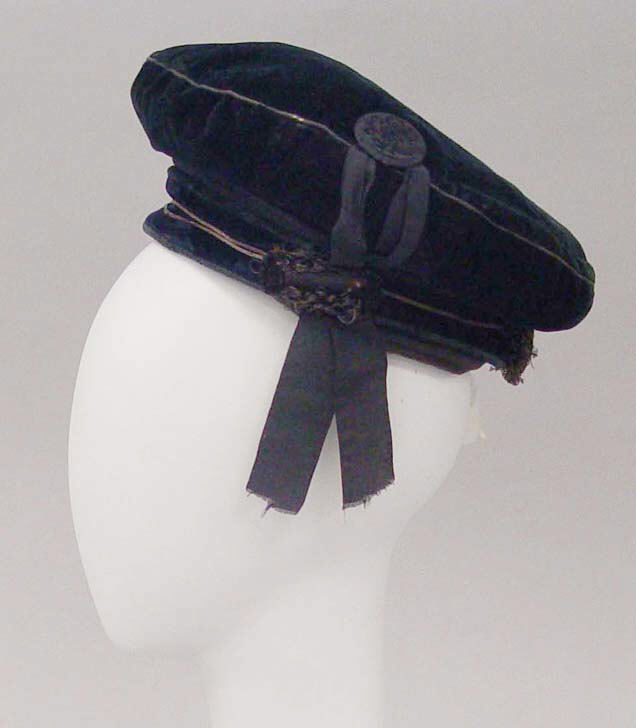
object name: sailor hat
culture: american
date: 1834-1866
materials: silk